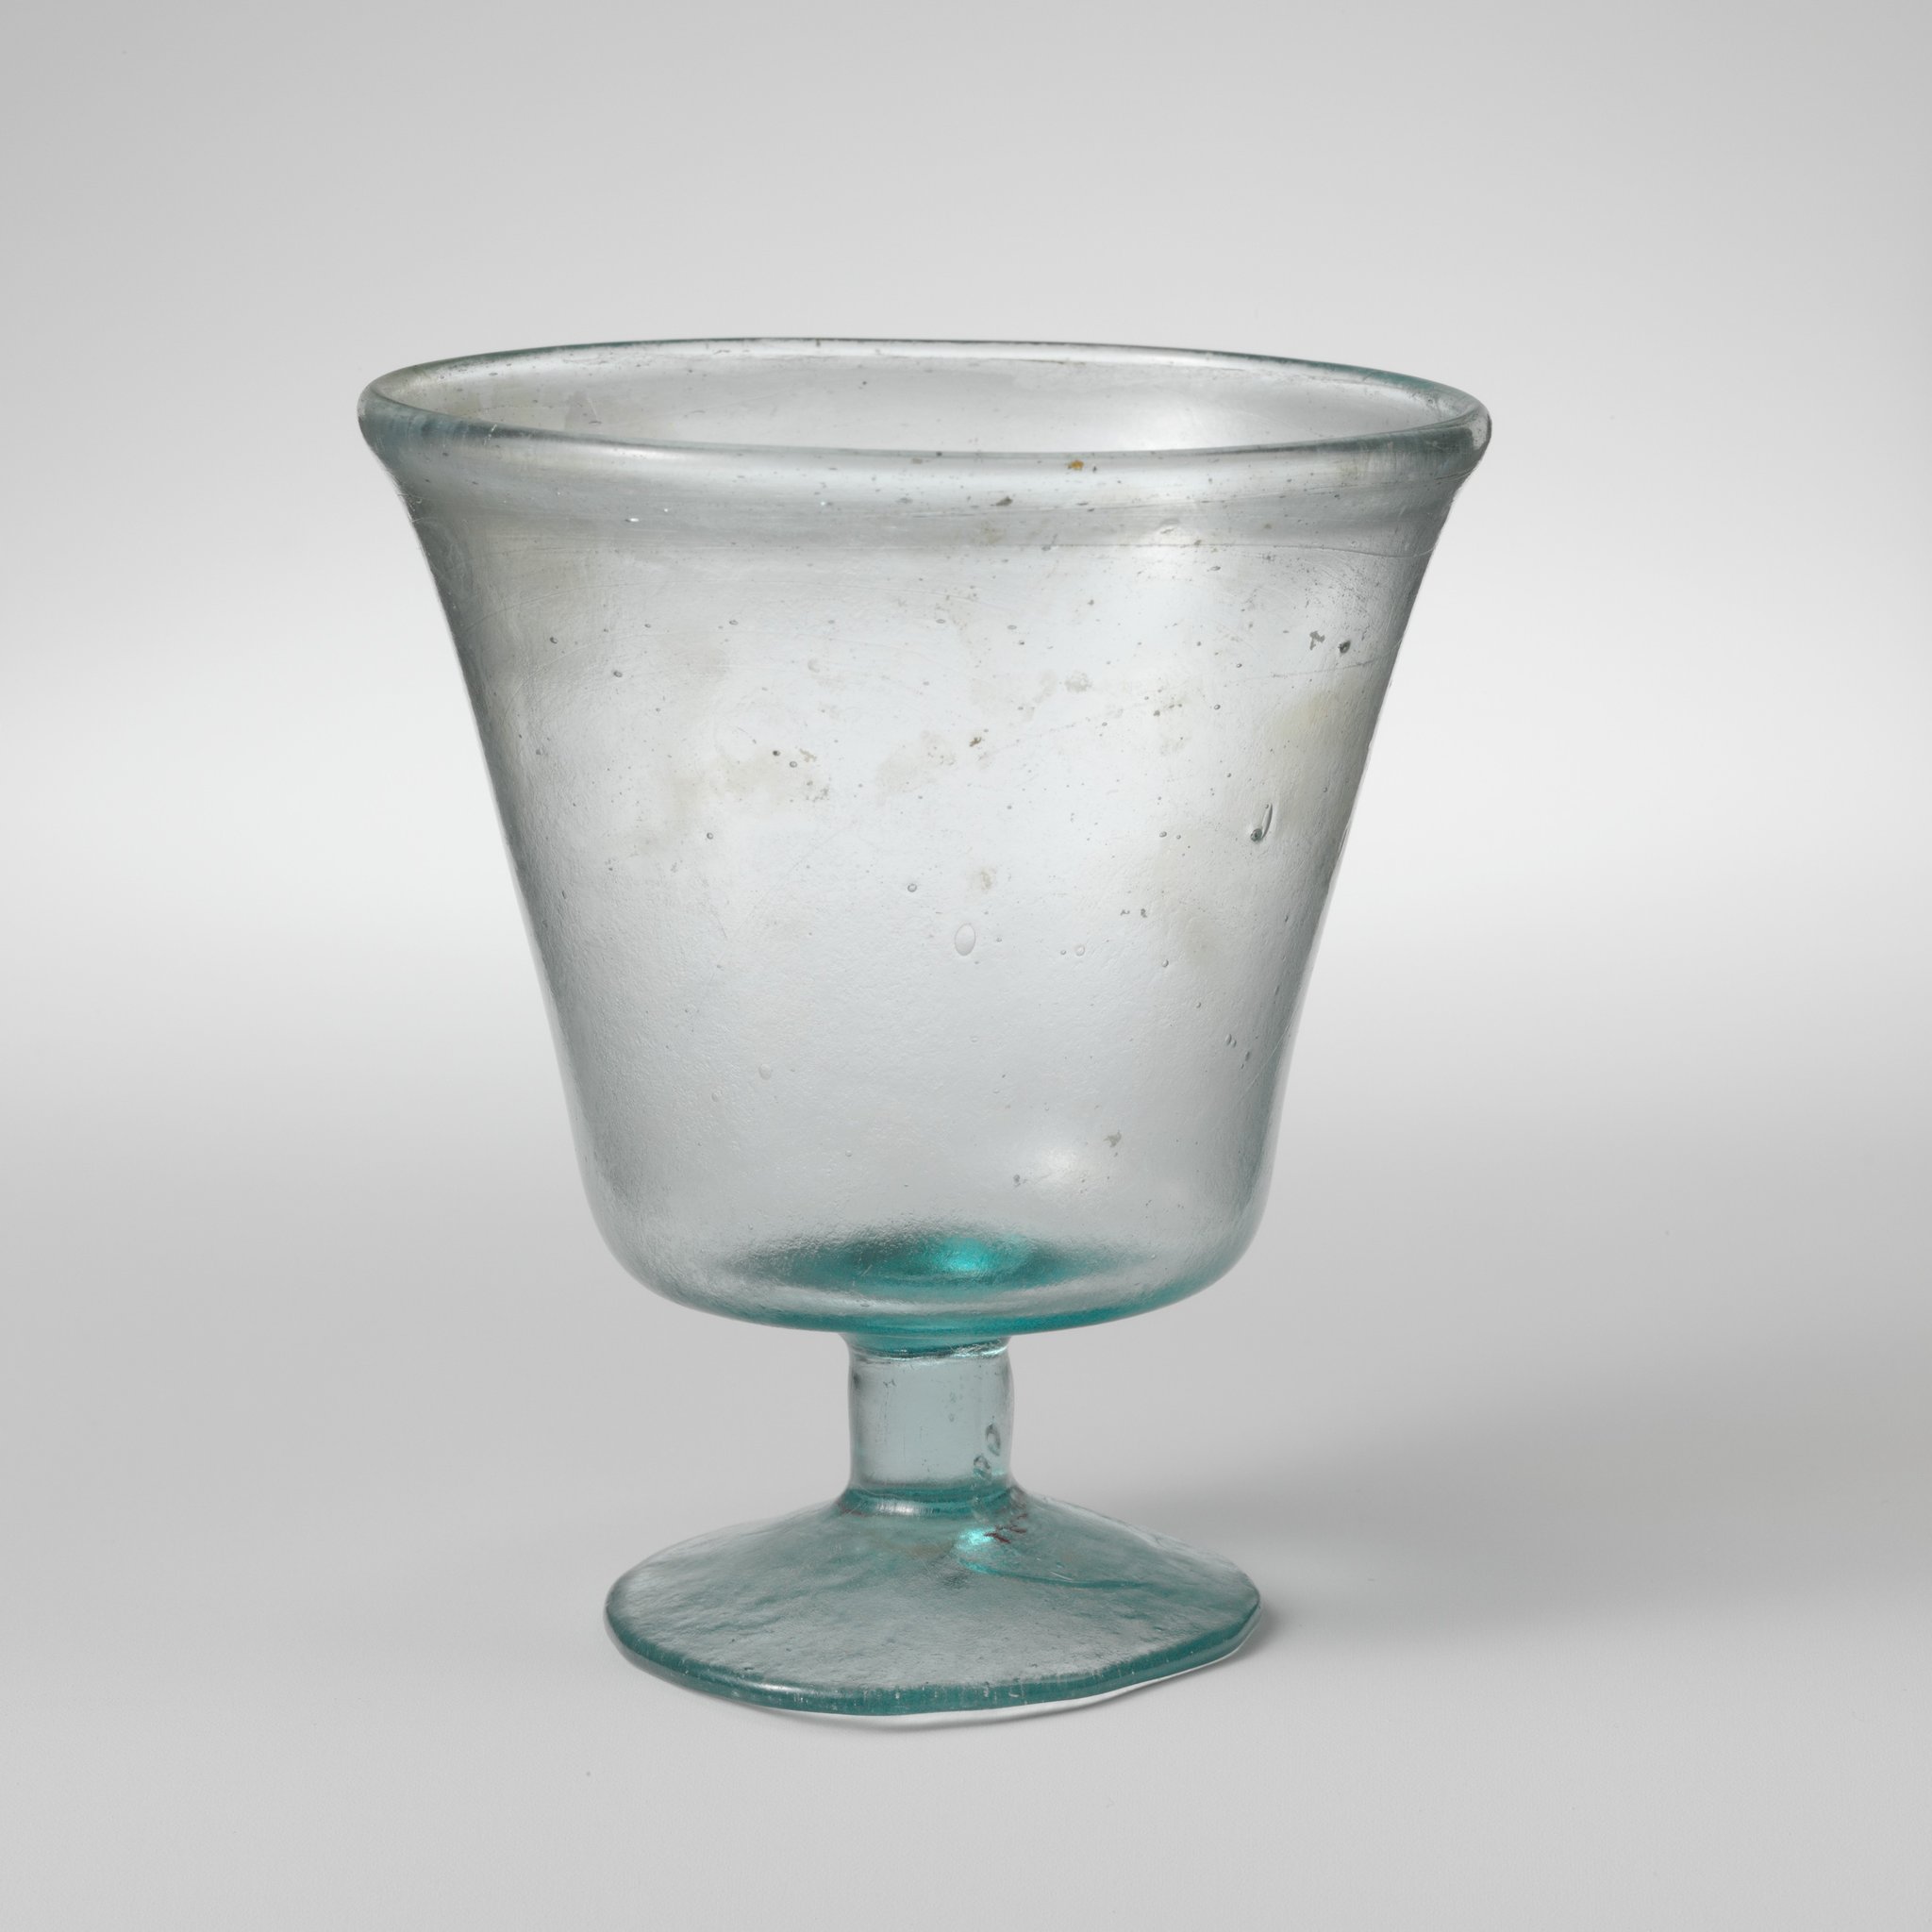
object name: goblet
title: Glass goblet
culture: roman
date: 301-600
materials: glass